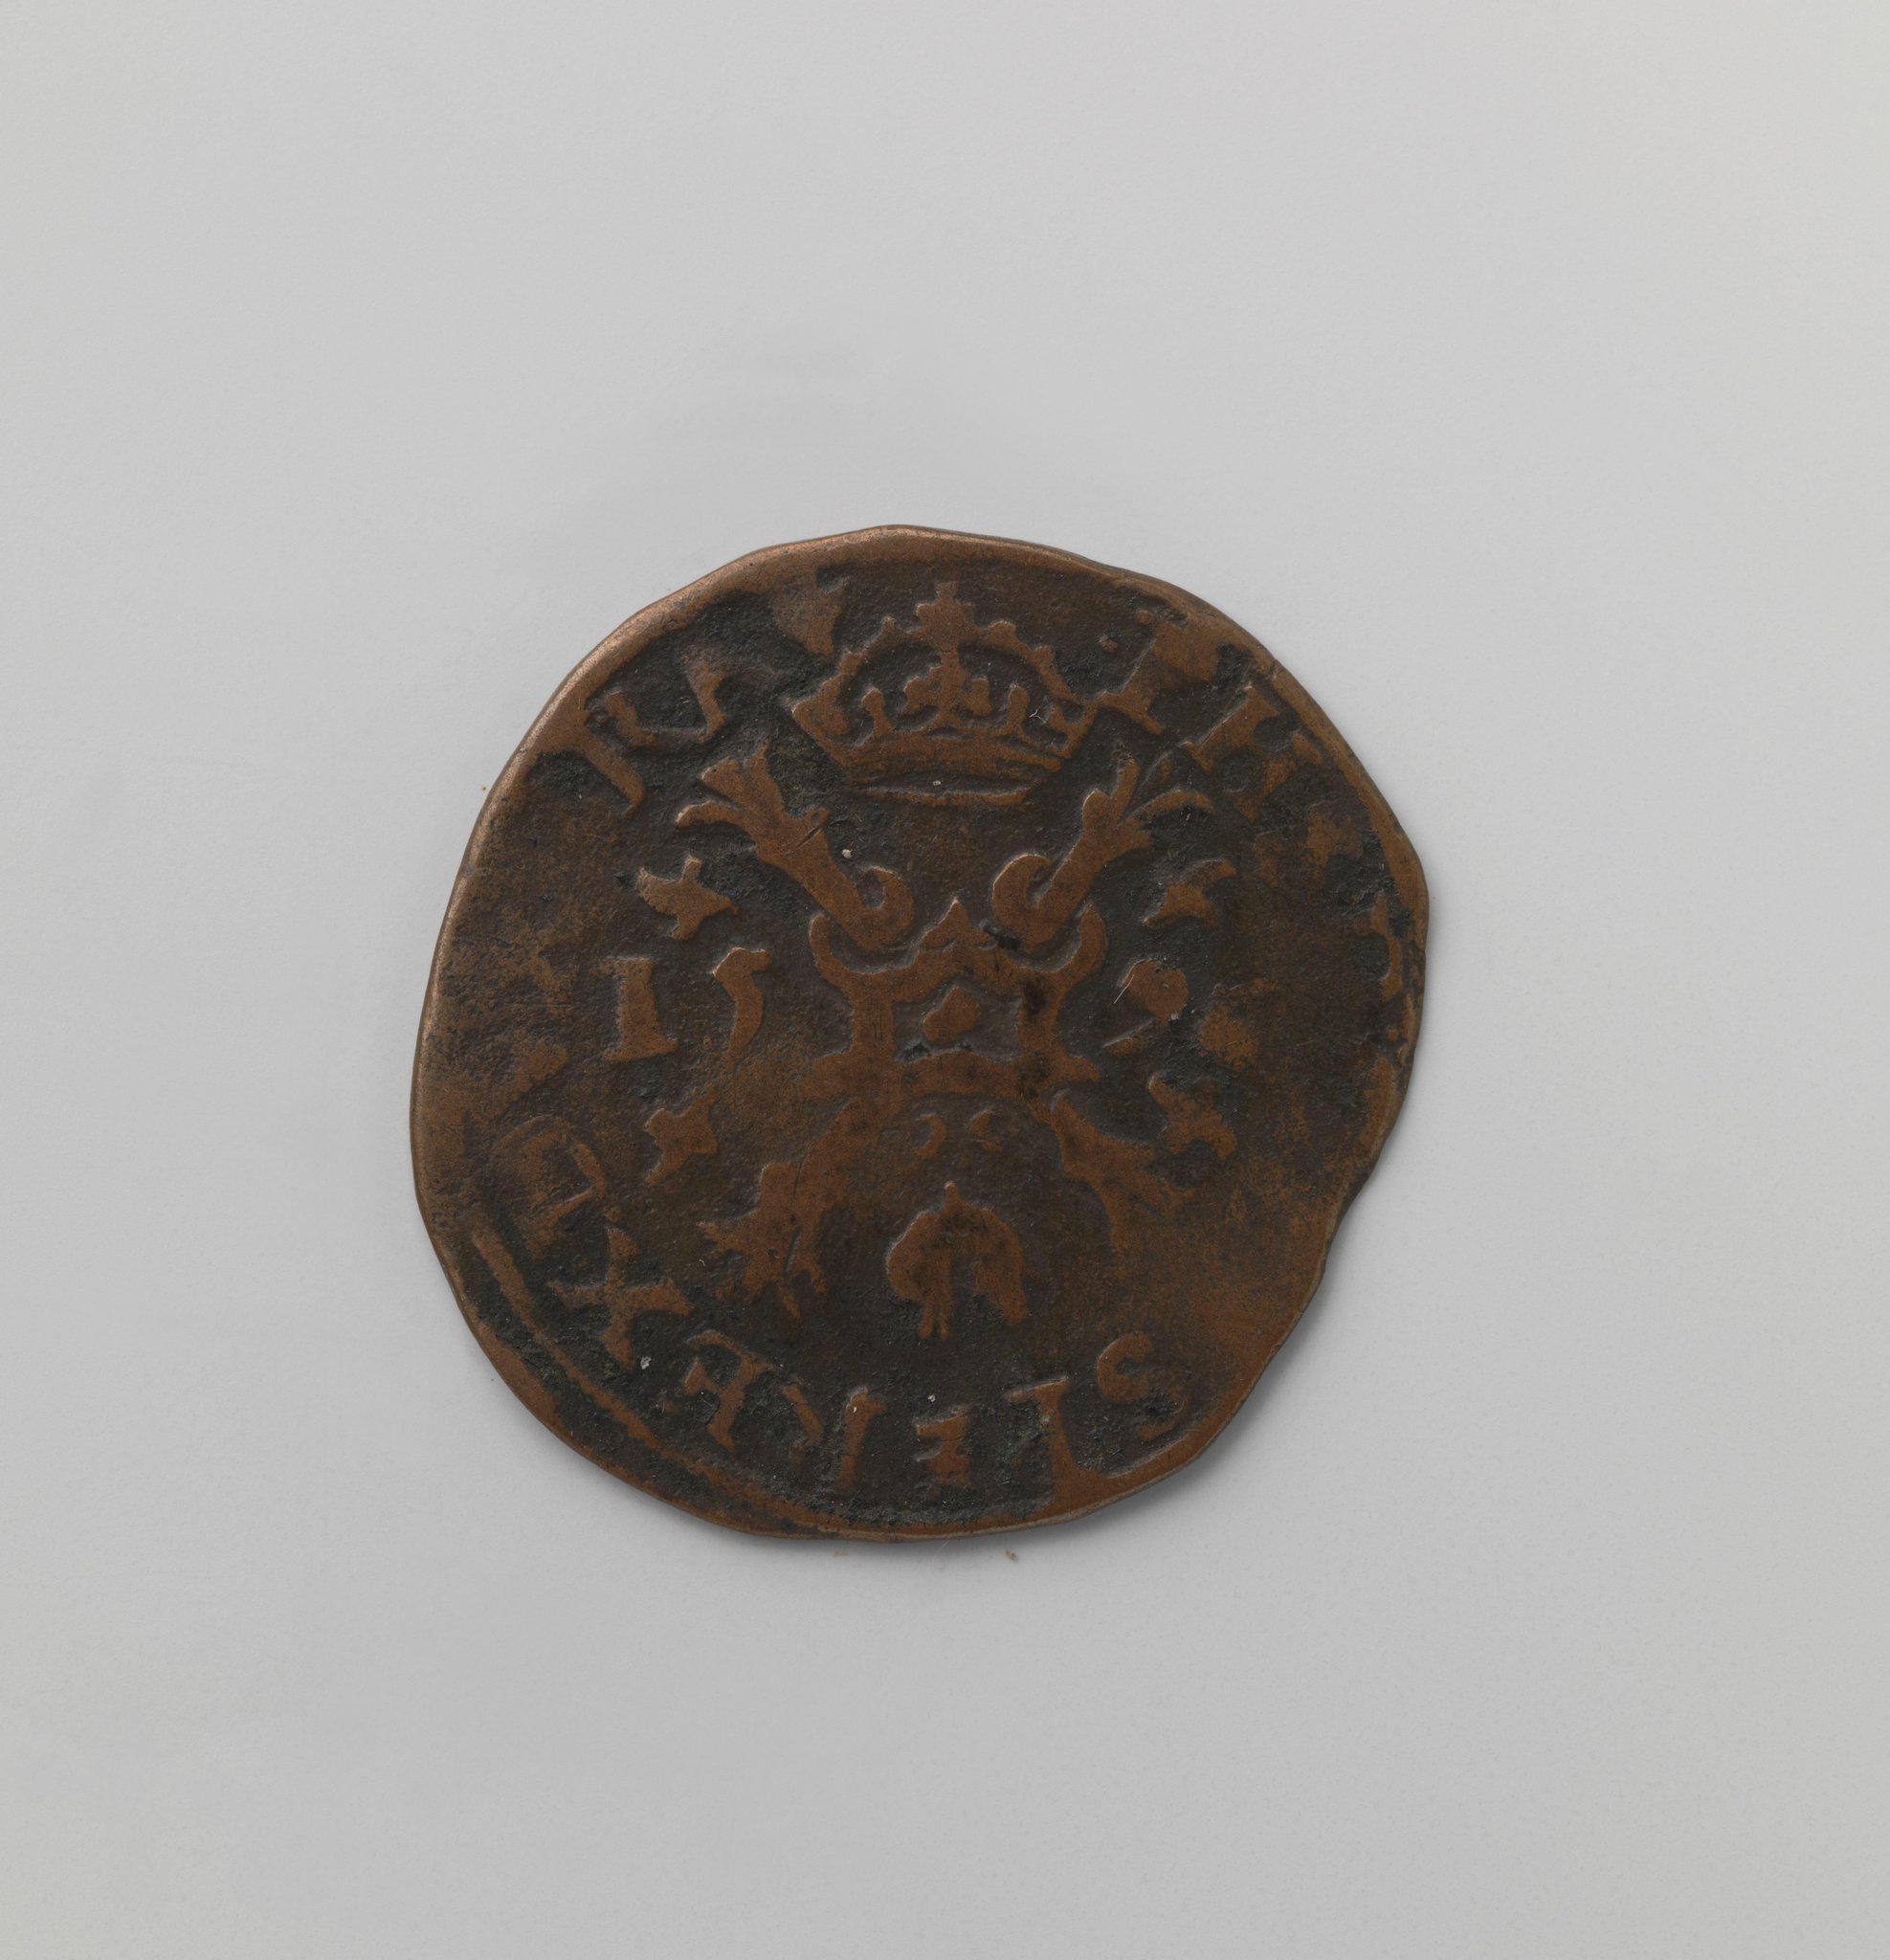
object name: coin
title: Brabant, Philips II, duit, 1596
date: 1596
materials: copper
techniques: striking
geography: antwerp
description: Koperen munt. Voorzijde: gekroond samengesteld wapenschild. Keerzijde: tussen jaartal vuurijzer op stokkenkruis Daarboven kroon, daaronder gulden vlies..